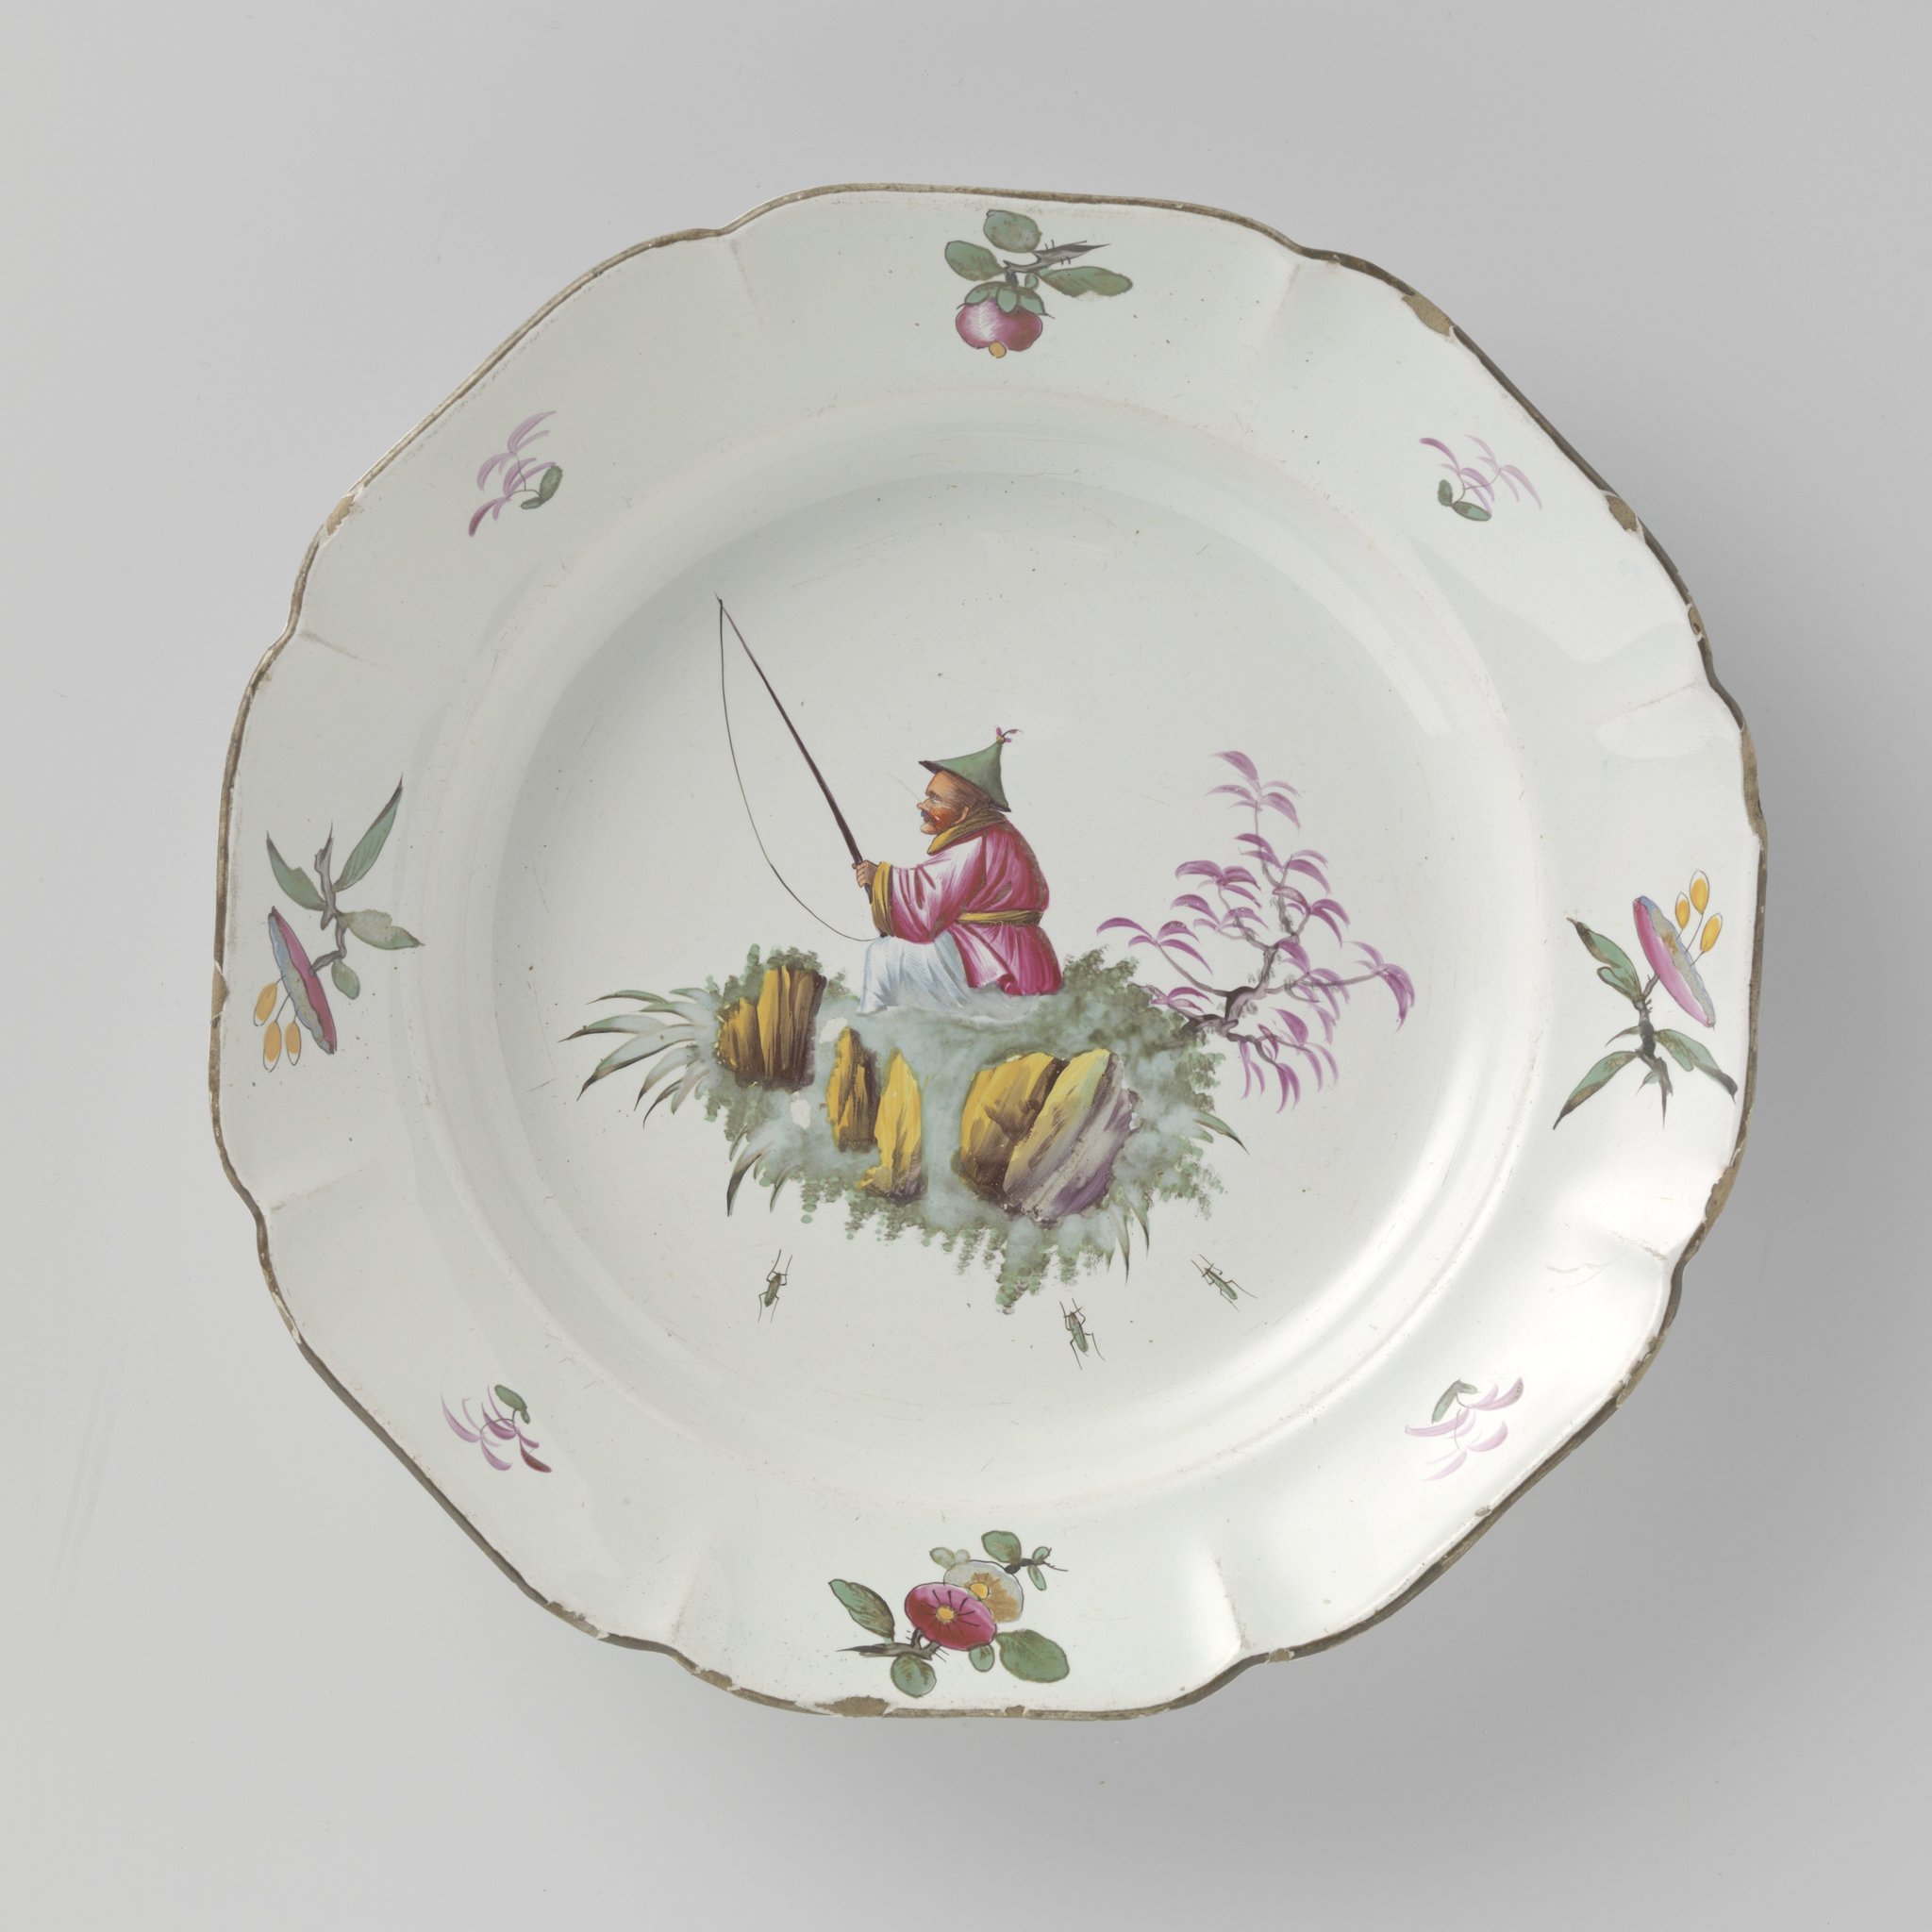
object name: plate dish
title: Bord, beschilderd met een Chinees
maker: joseph hannonge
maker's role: plateelbakker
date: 1760-1775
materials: faience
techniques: kiln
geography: straatsburg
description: Plate. Faience with petit feu decoration. Strasbourg (France), c. 1760 - 1775. Factory of Joseph Hannong. J.G.A.N. de Vries bequest, 1925.